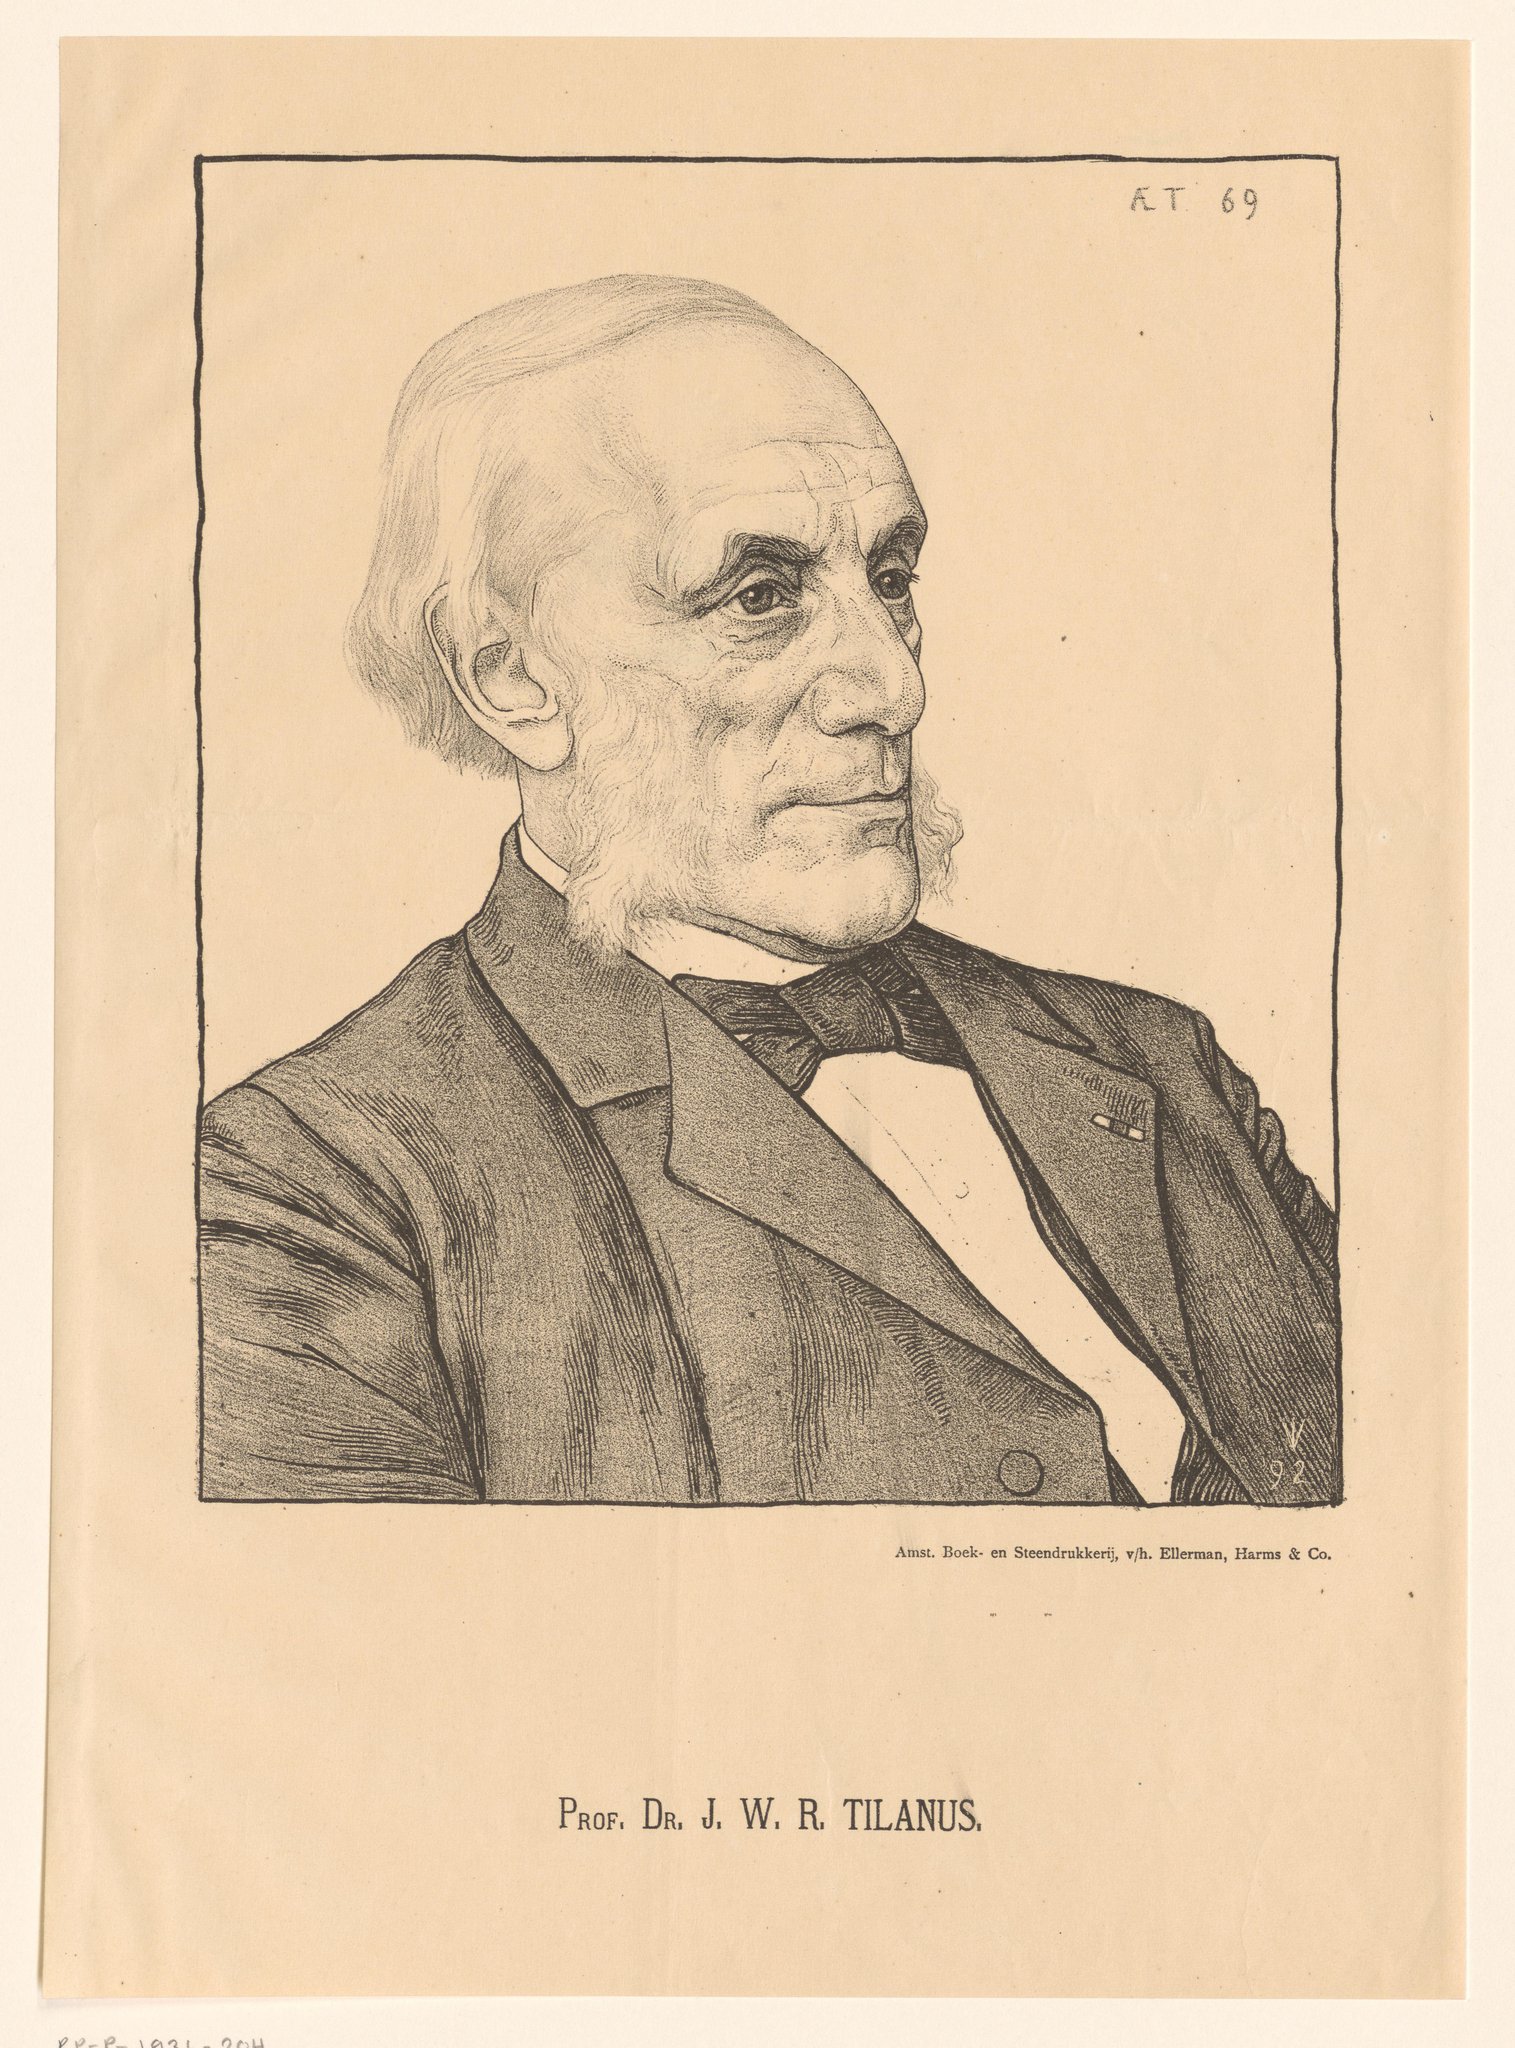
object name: print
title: Portret van Jan Willem Reinier Tilanus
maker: jan veth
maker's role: designer, draughtsman, painter, print maker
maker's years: 1864-1925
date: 1892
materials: paper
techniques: lithograph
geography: amsterdam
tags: arnhem, jan willem reinier tilanus, historical persons, professor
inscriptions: collector's mark: Lugt 2228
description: Prent waarschijnlijk verschenen in het bijvoegsel van: De Amsterdammer, Weekblad voor Nederland, 4 december 1892.